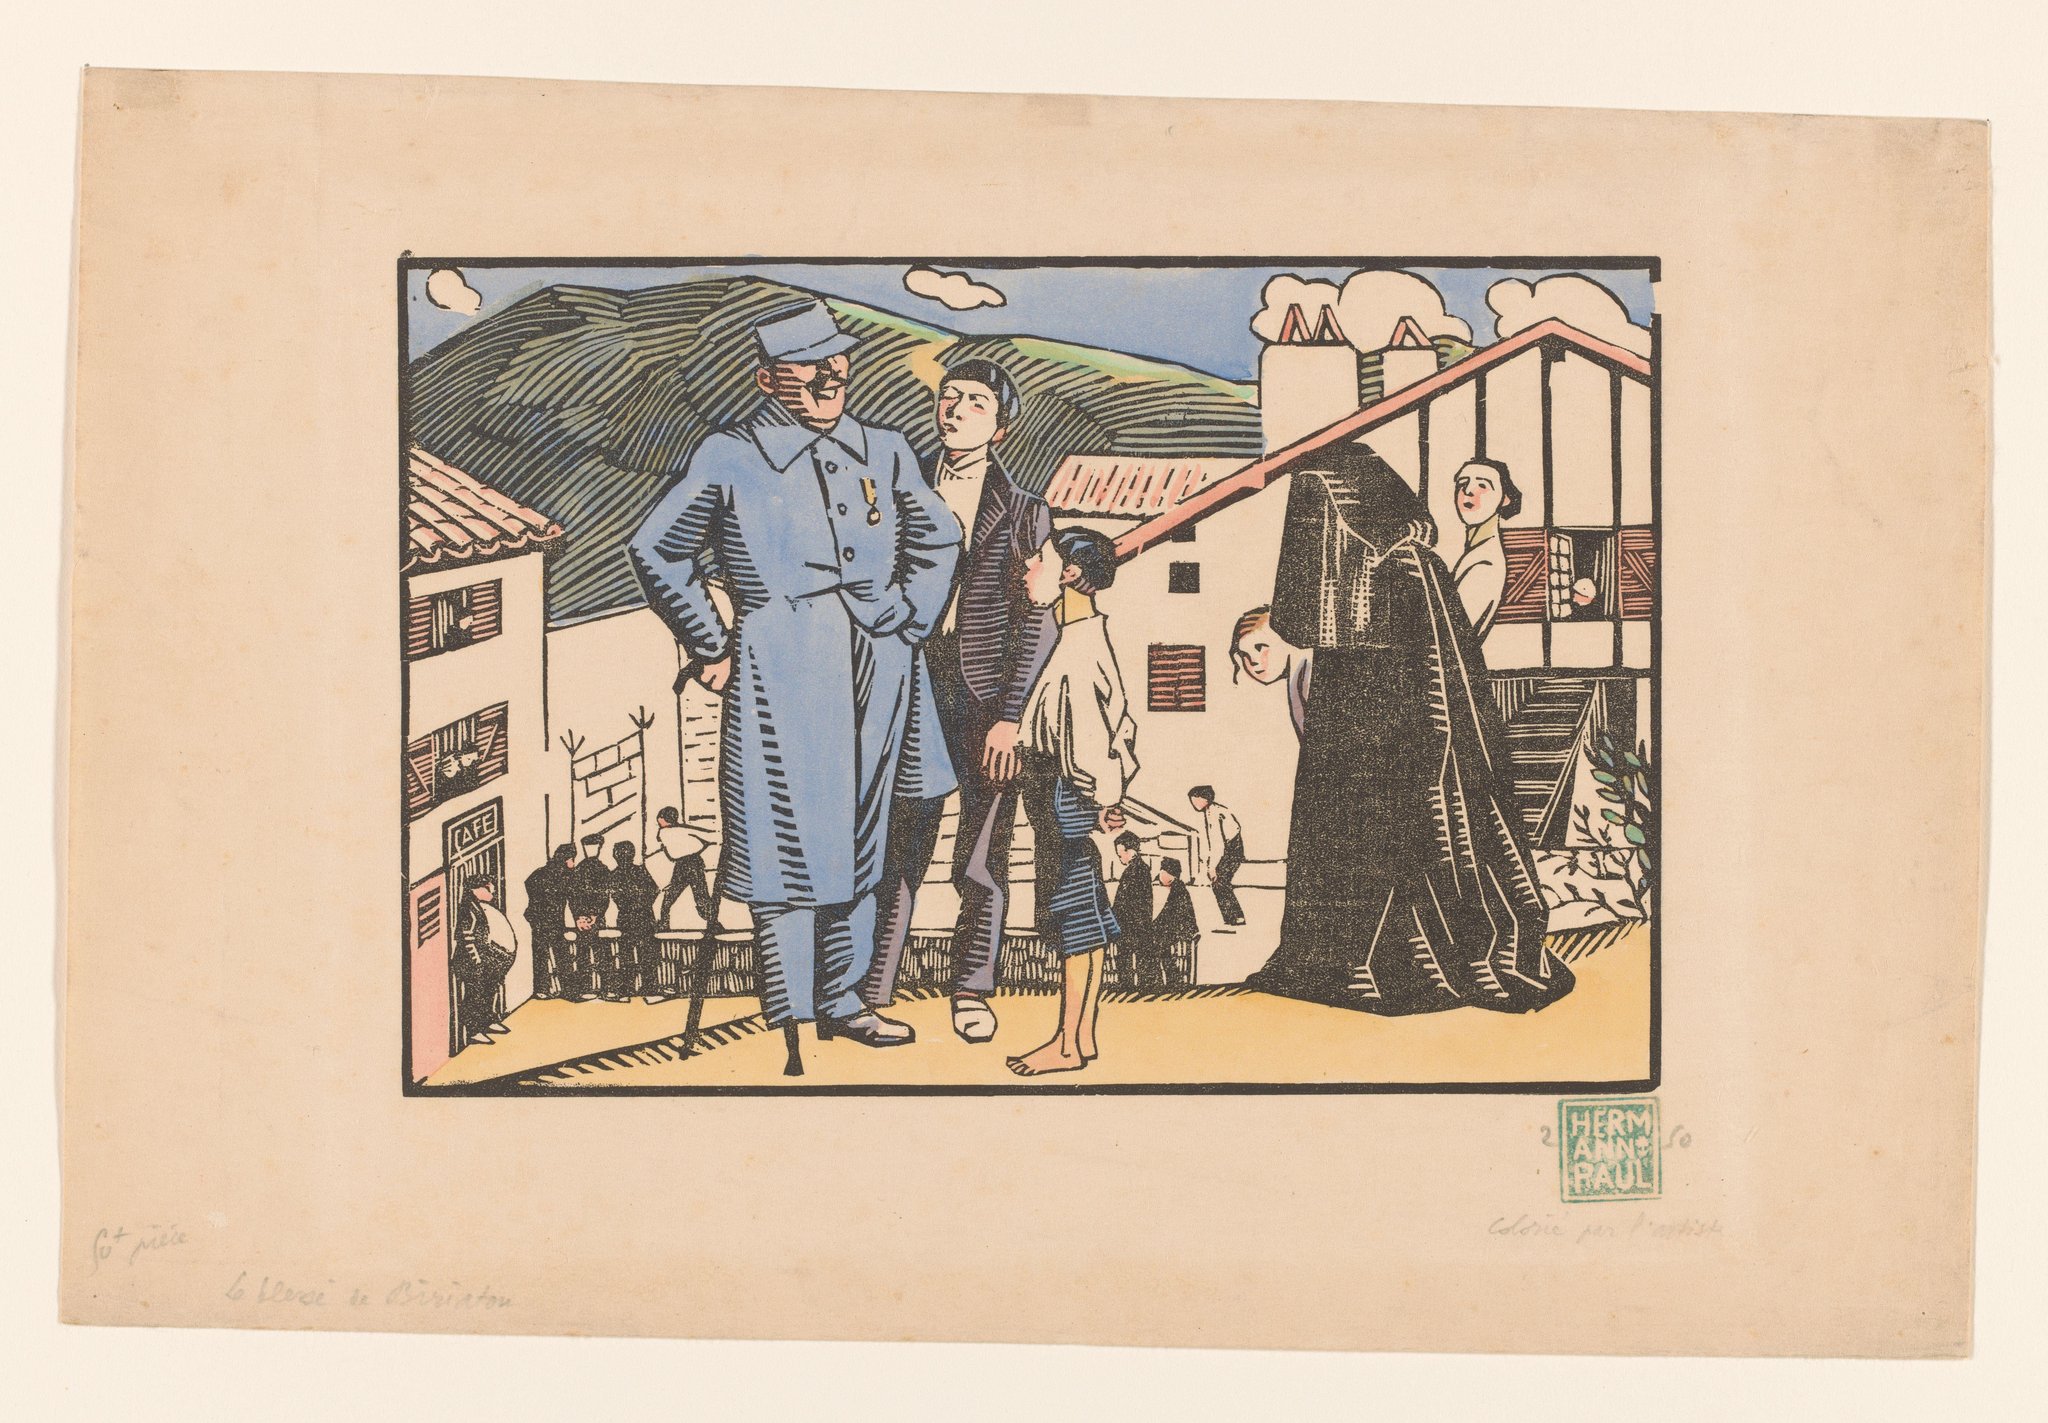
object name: print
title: Le blessé de Biriatou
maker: georges hermann rene paul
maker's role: painter, print maker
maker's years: 1864-1940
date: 1874-1940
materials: paper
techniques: hand coloring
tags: village street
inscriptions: workshop stamp: ‘Hermann: Paul’, collector's mark: Lugt 2228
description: Dorpsgezicht met verschillende figuren op straat.